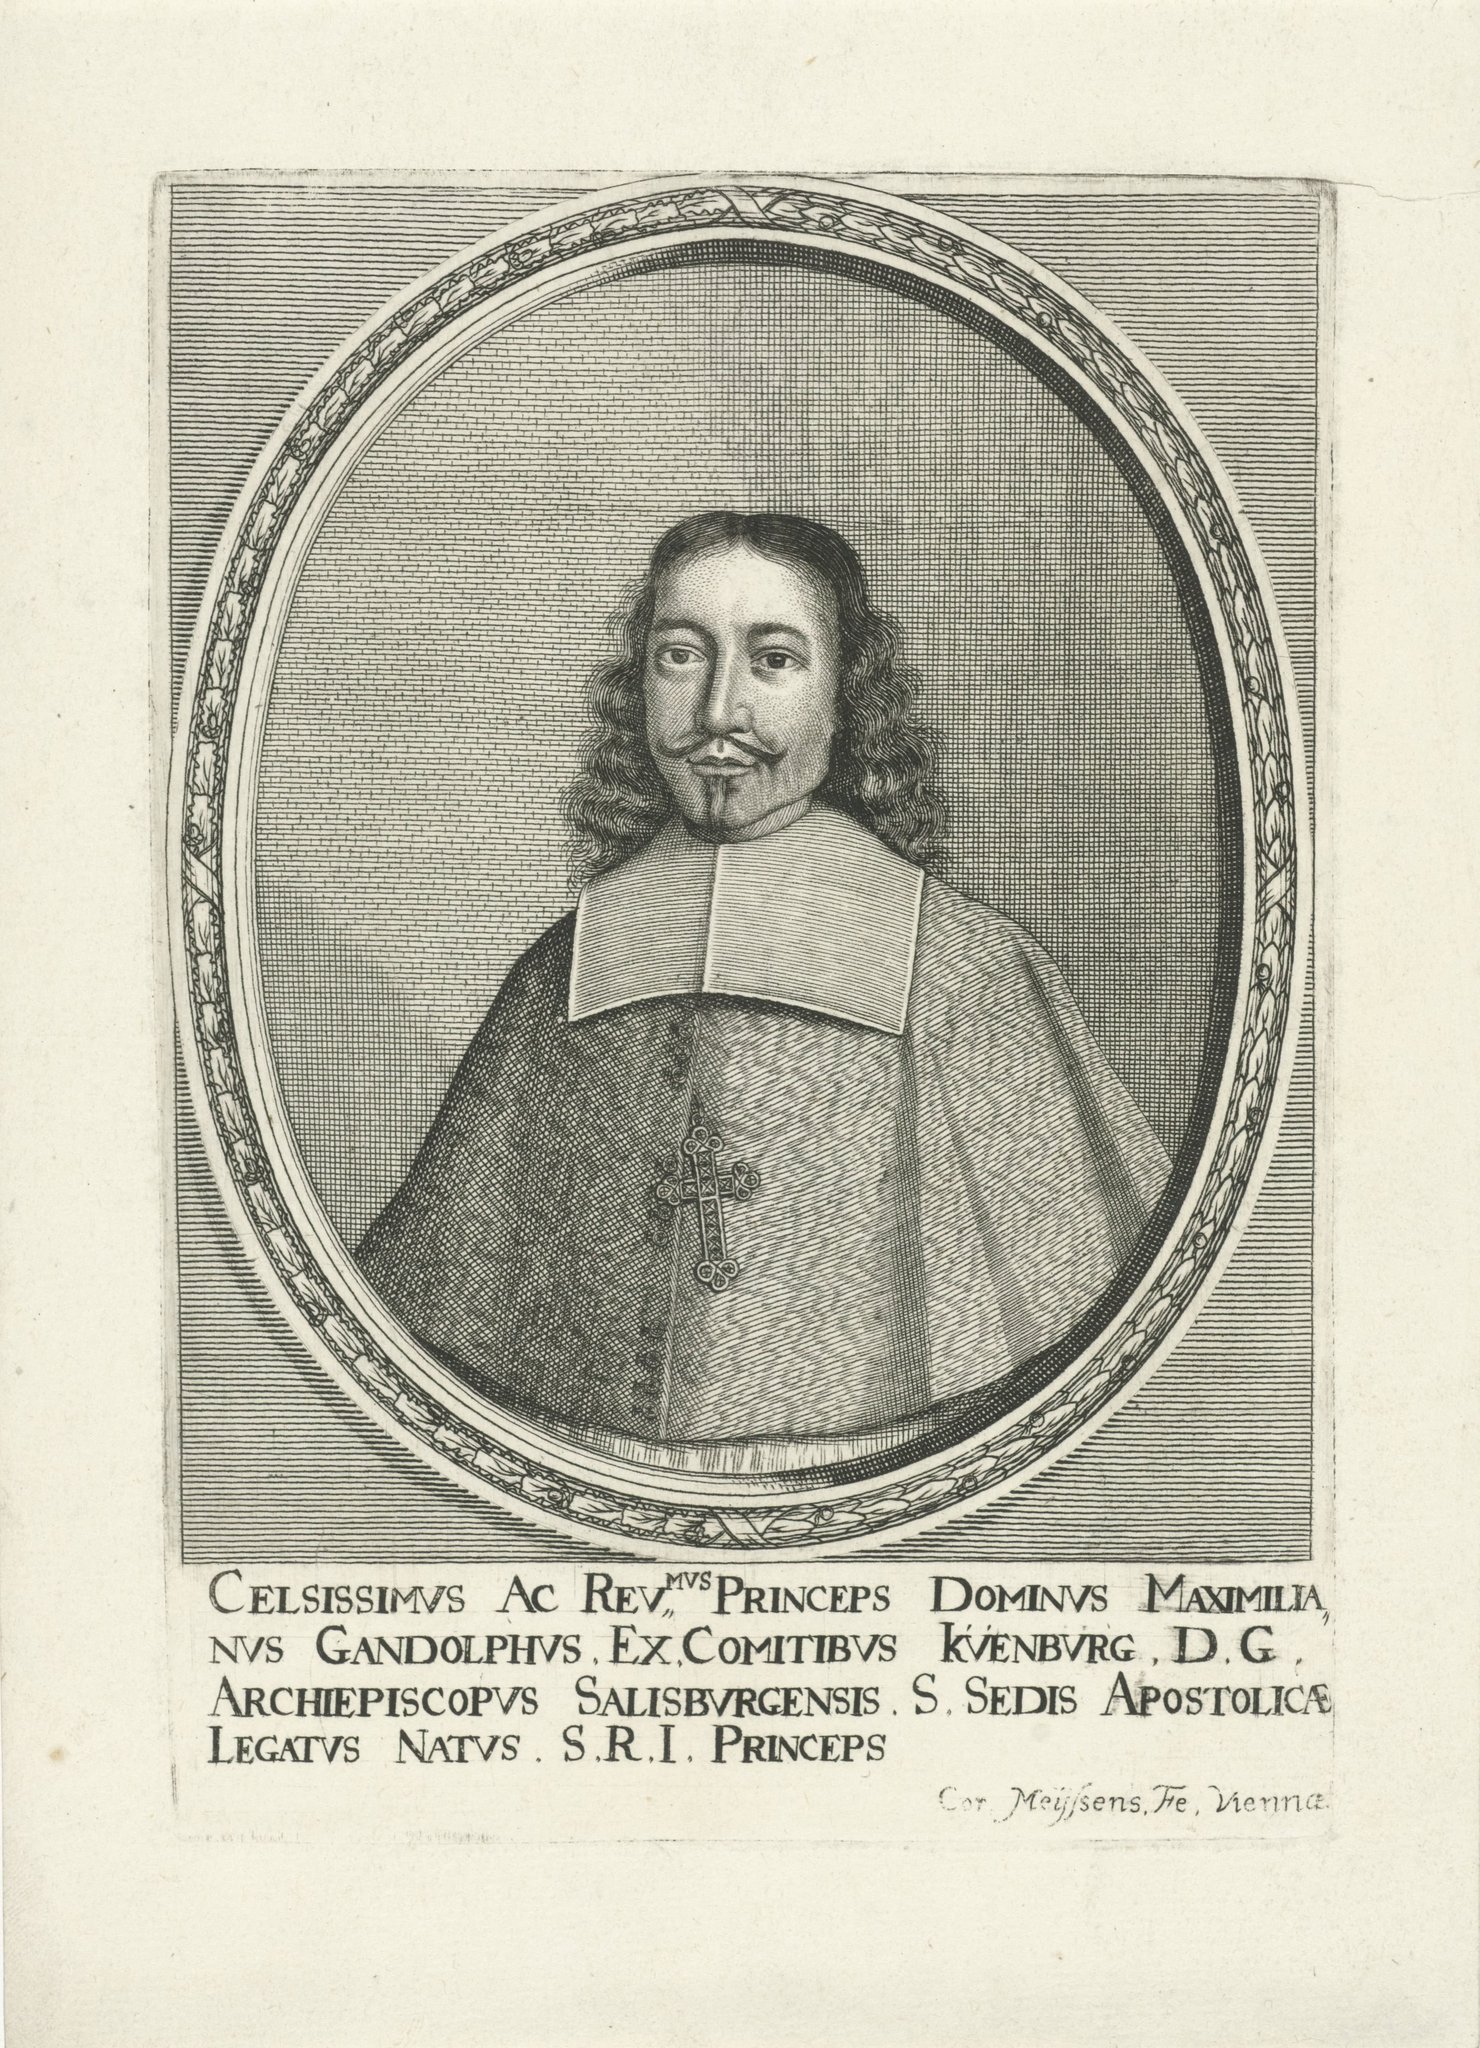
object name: print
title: Portret van Maximilian Gandolph graaf van Kuenburg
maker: cornelis meyssens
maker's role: print maker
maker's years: 1640-1673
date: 1660-1693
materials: paper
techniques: engraving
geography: vienna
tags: graz, salzburg, kardinaal, aartsbisschop, maximilian gandolf von kuenburg (graaf)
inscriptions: collector's mark: Lugt 2228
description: Portret van Maximilian Gandolph, graaf van Kuenburg en aartsbisschop van Salzburg. Onderaan in de marge een vierregelige tekst in het Latijn.